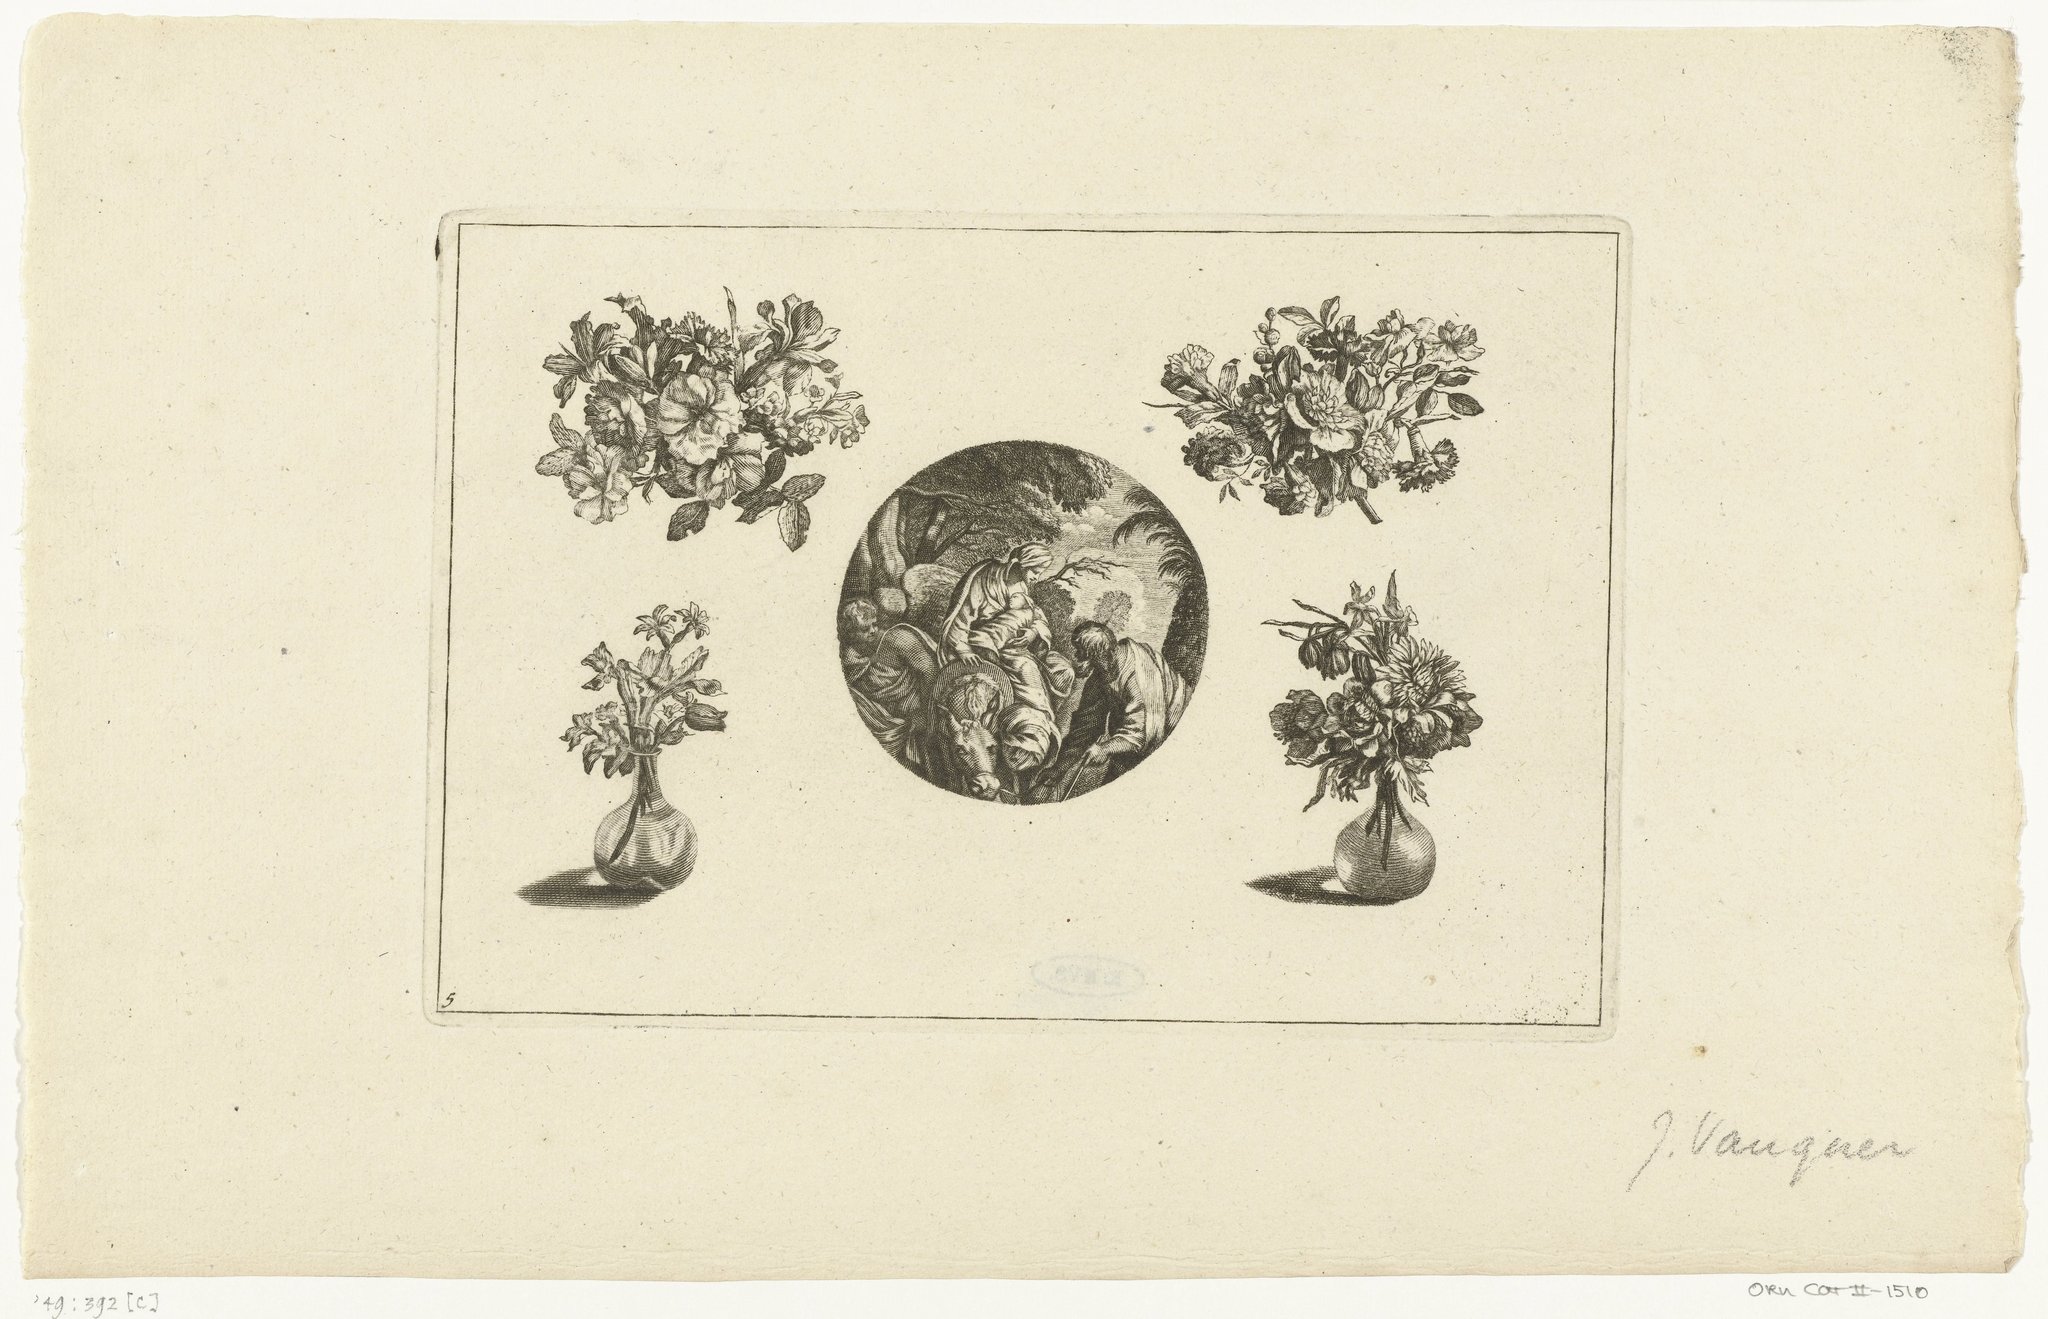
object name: ornament print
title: Horlogekasten: deksels en zijkanten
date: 1661-1726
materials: paper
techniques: engraving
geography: france